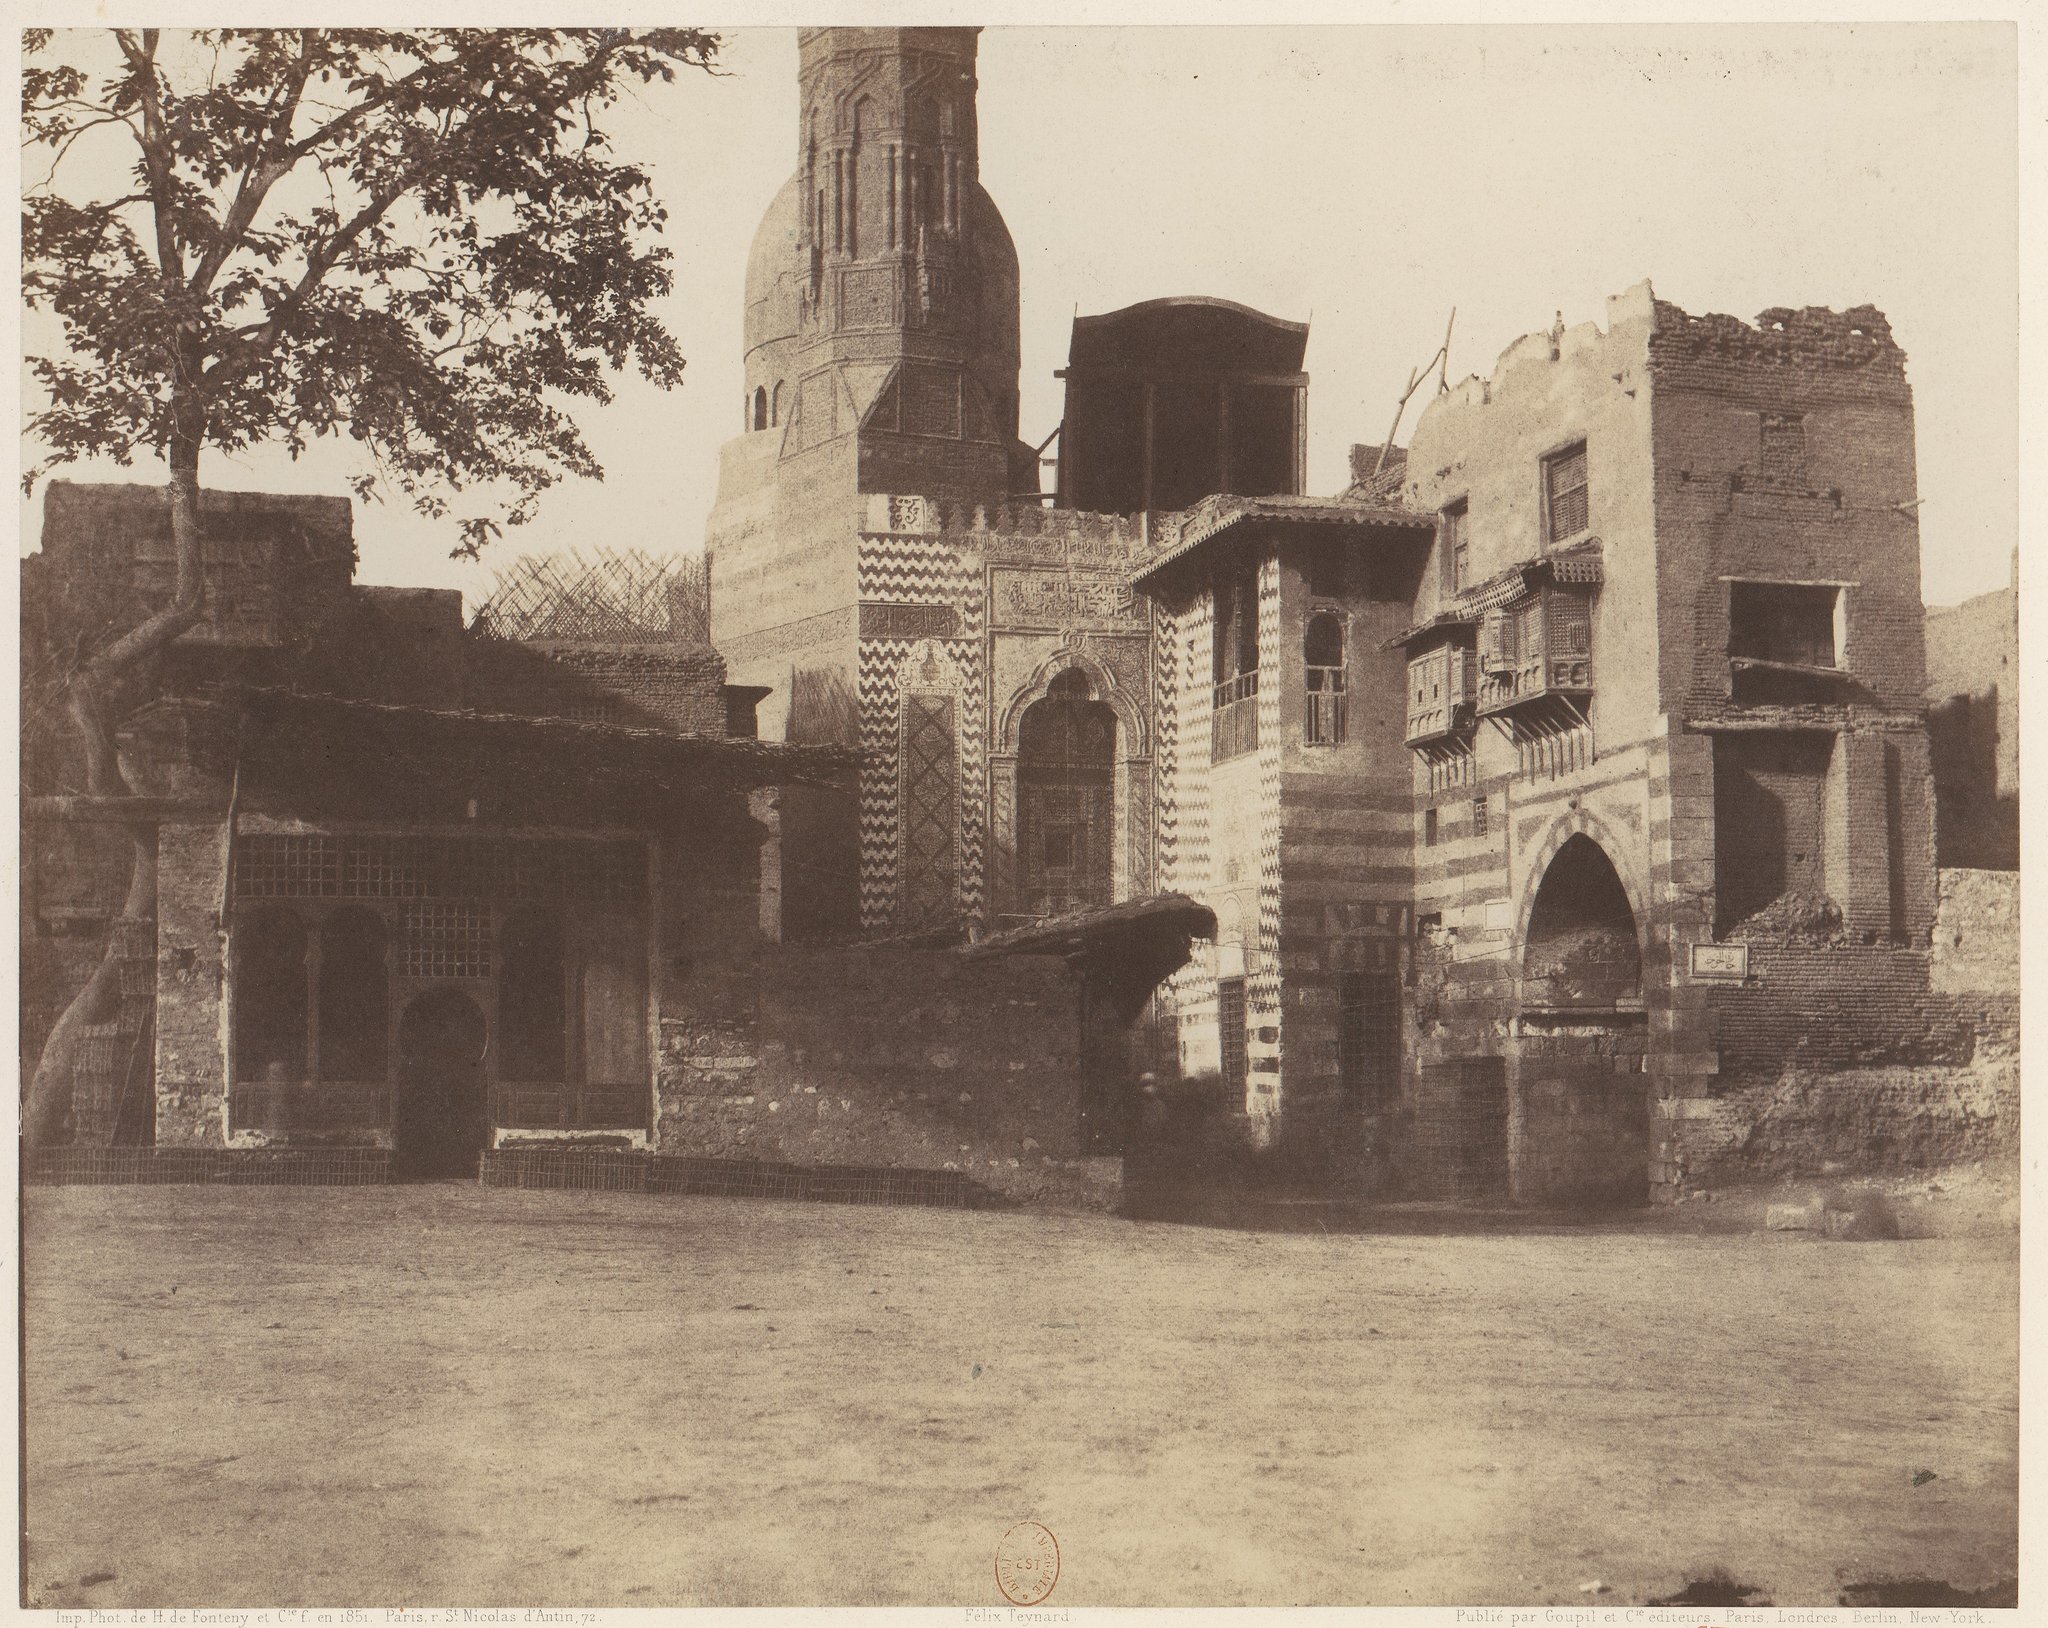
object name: photograph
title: Boûlâk, Carrefour (Mosquée, Café, etc.)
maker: félix teynard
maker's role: artist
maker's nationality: french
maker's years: 1817-1892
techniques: paper negative, salted paper print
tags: architecture,buildings,mosques